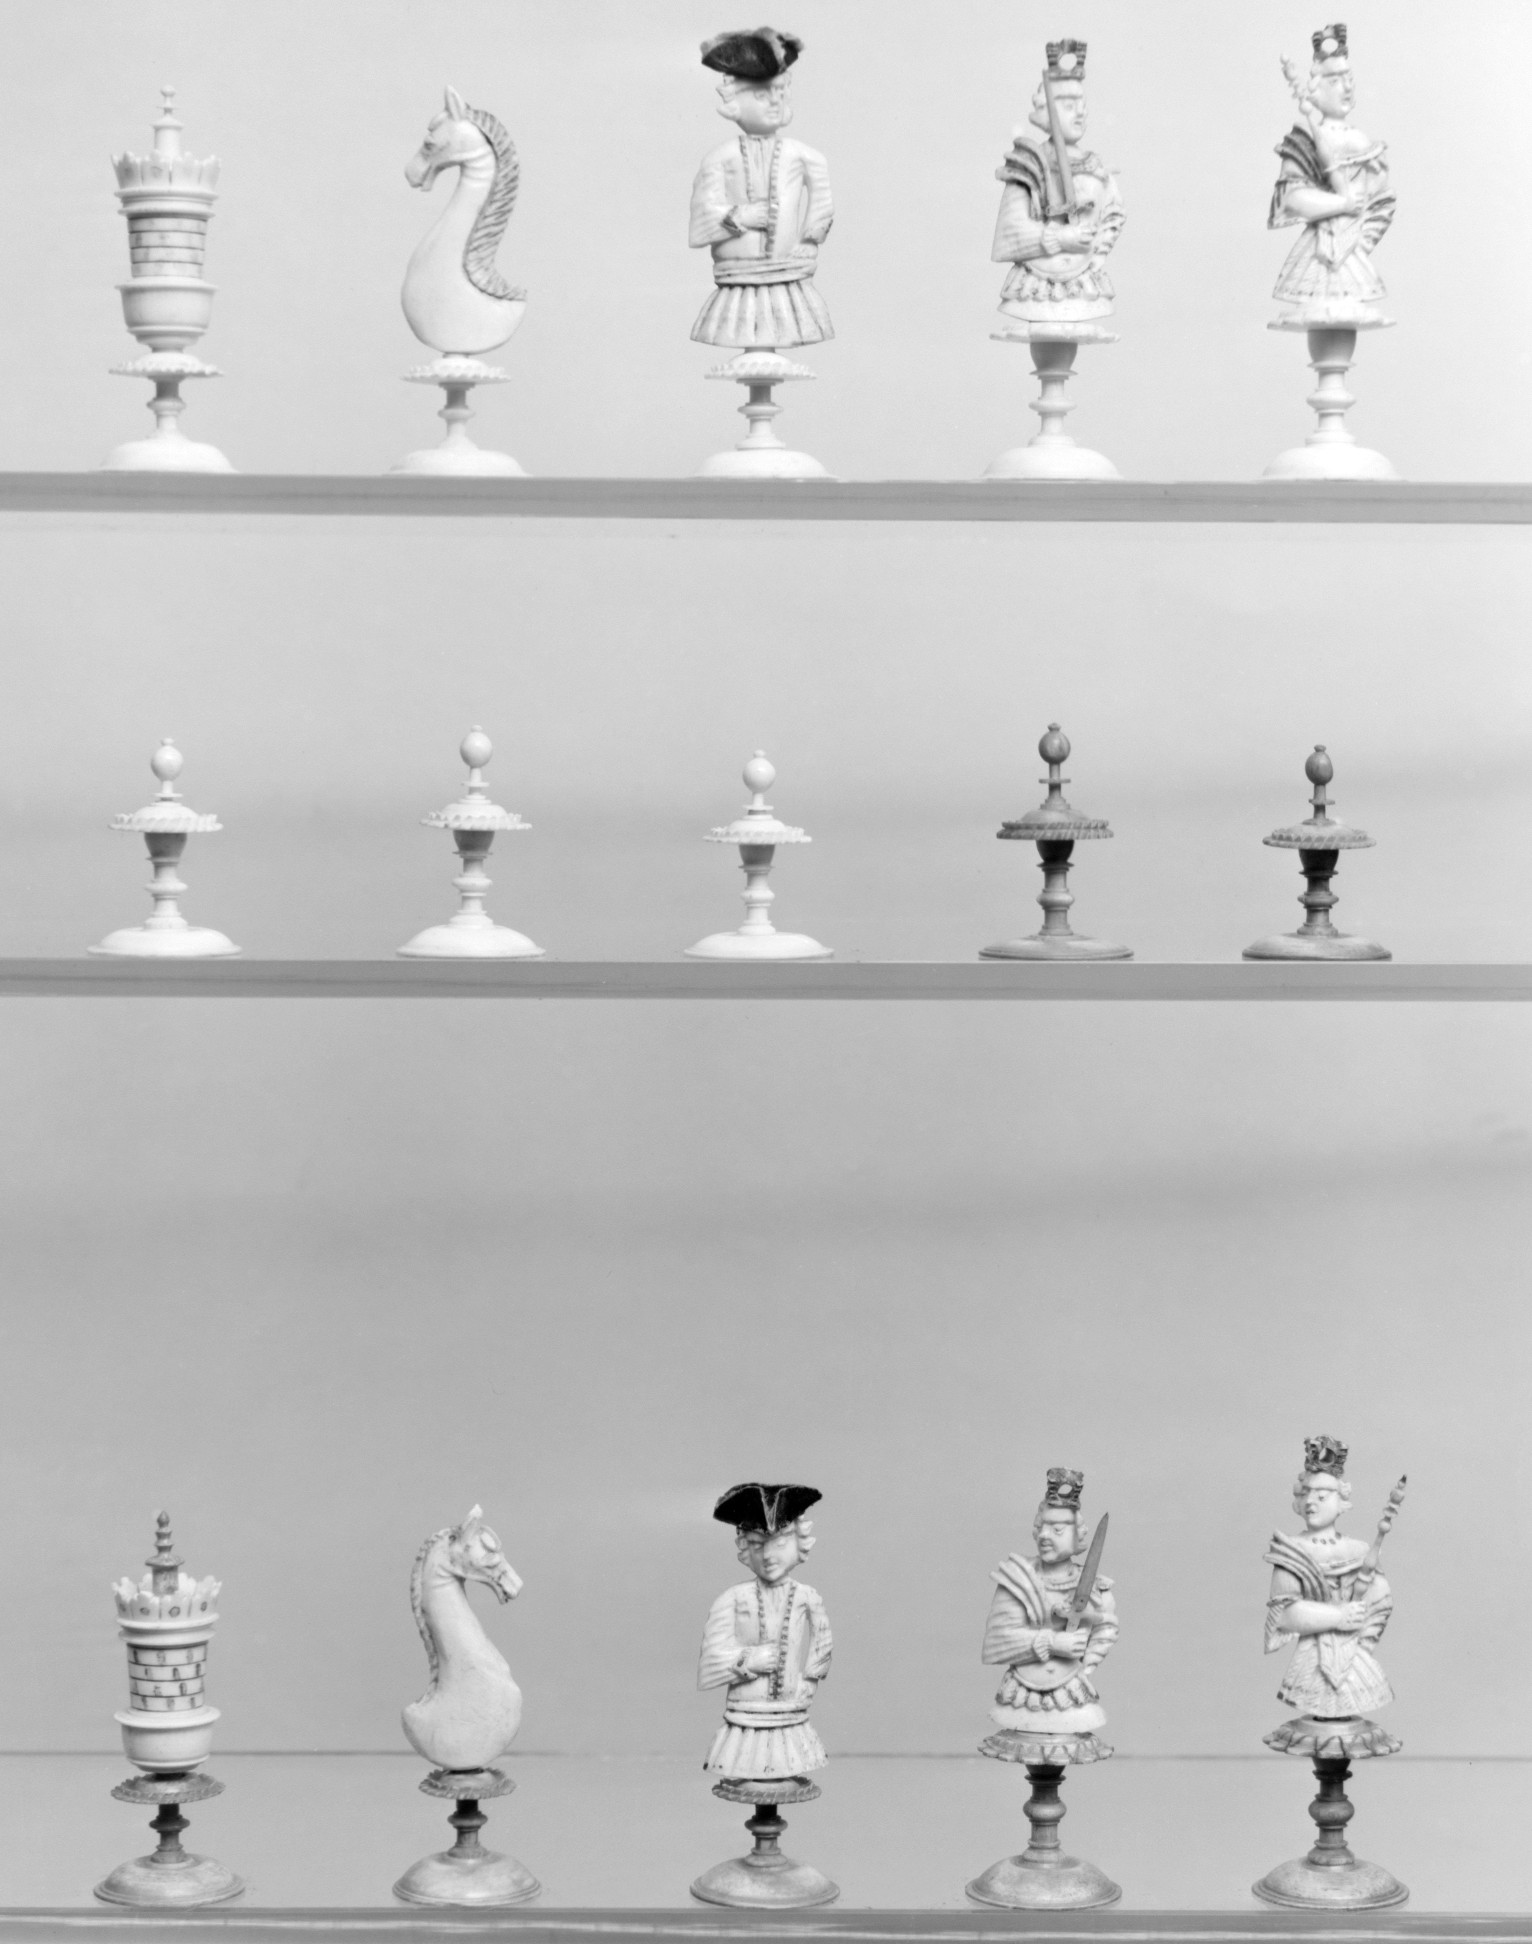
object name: chessman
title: Chessmen (32)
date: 1750-1775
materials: bone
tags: chess,games